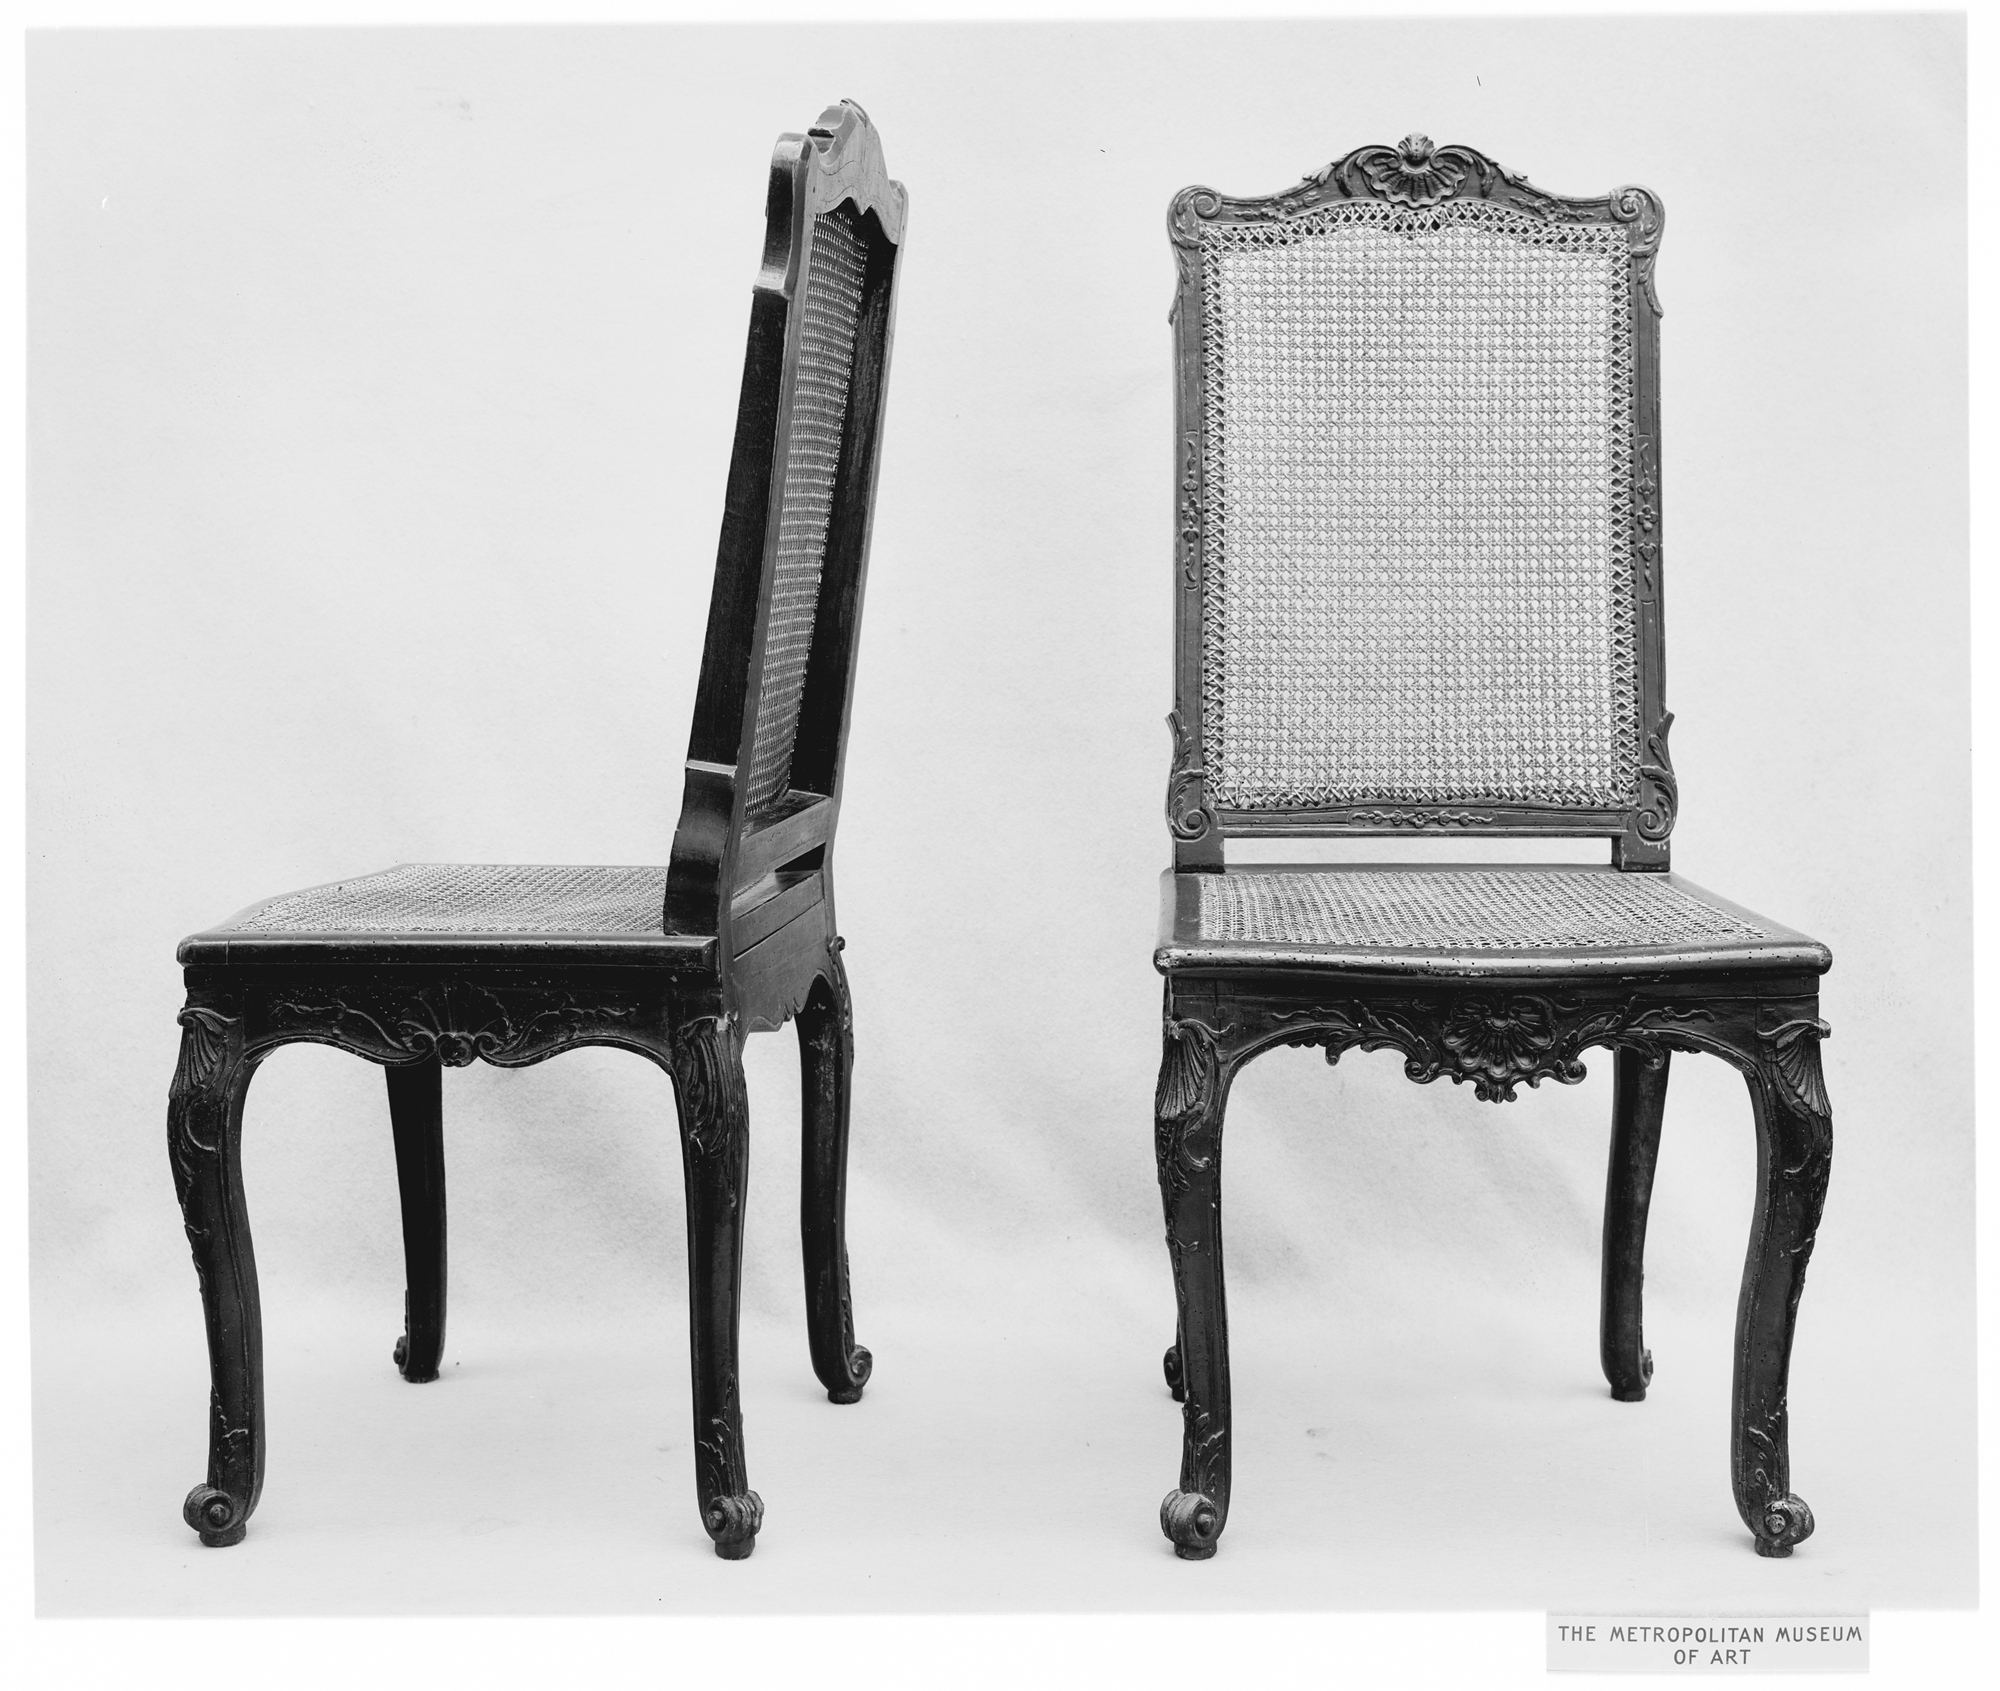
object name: side chair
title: Pair of side chairs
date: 1701-1725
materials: wood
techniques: painting